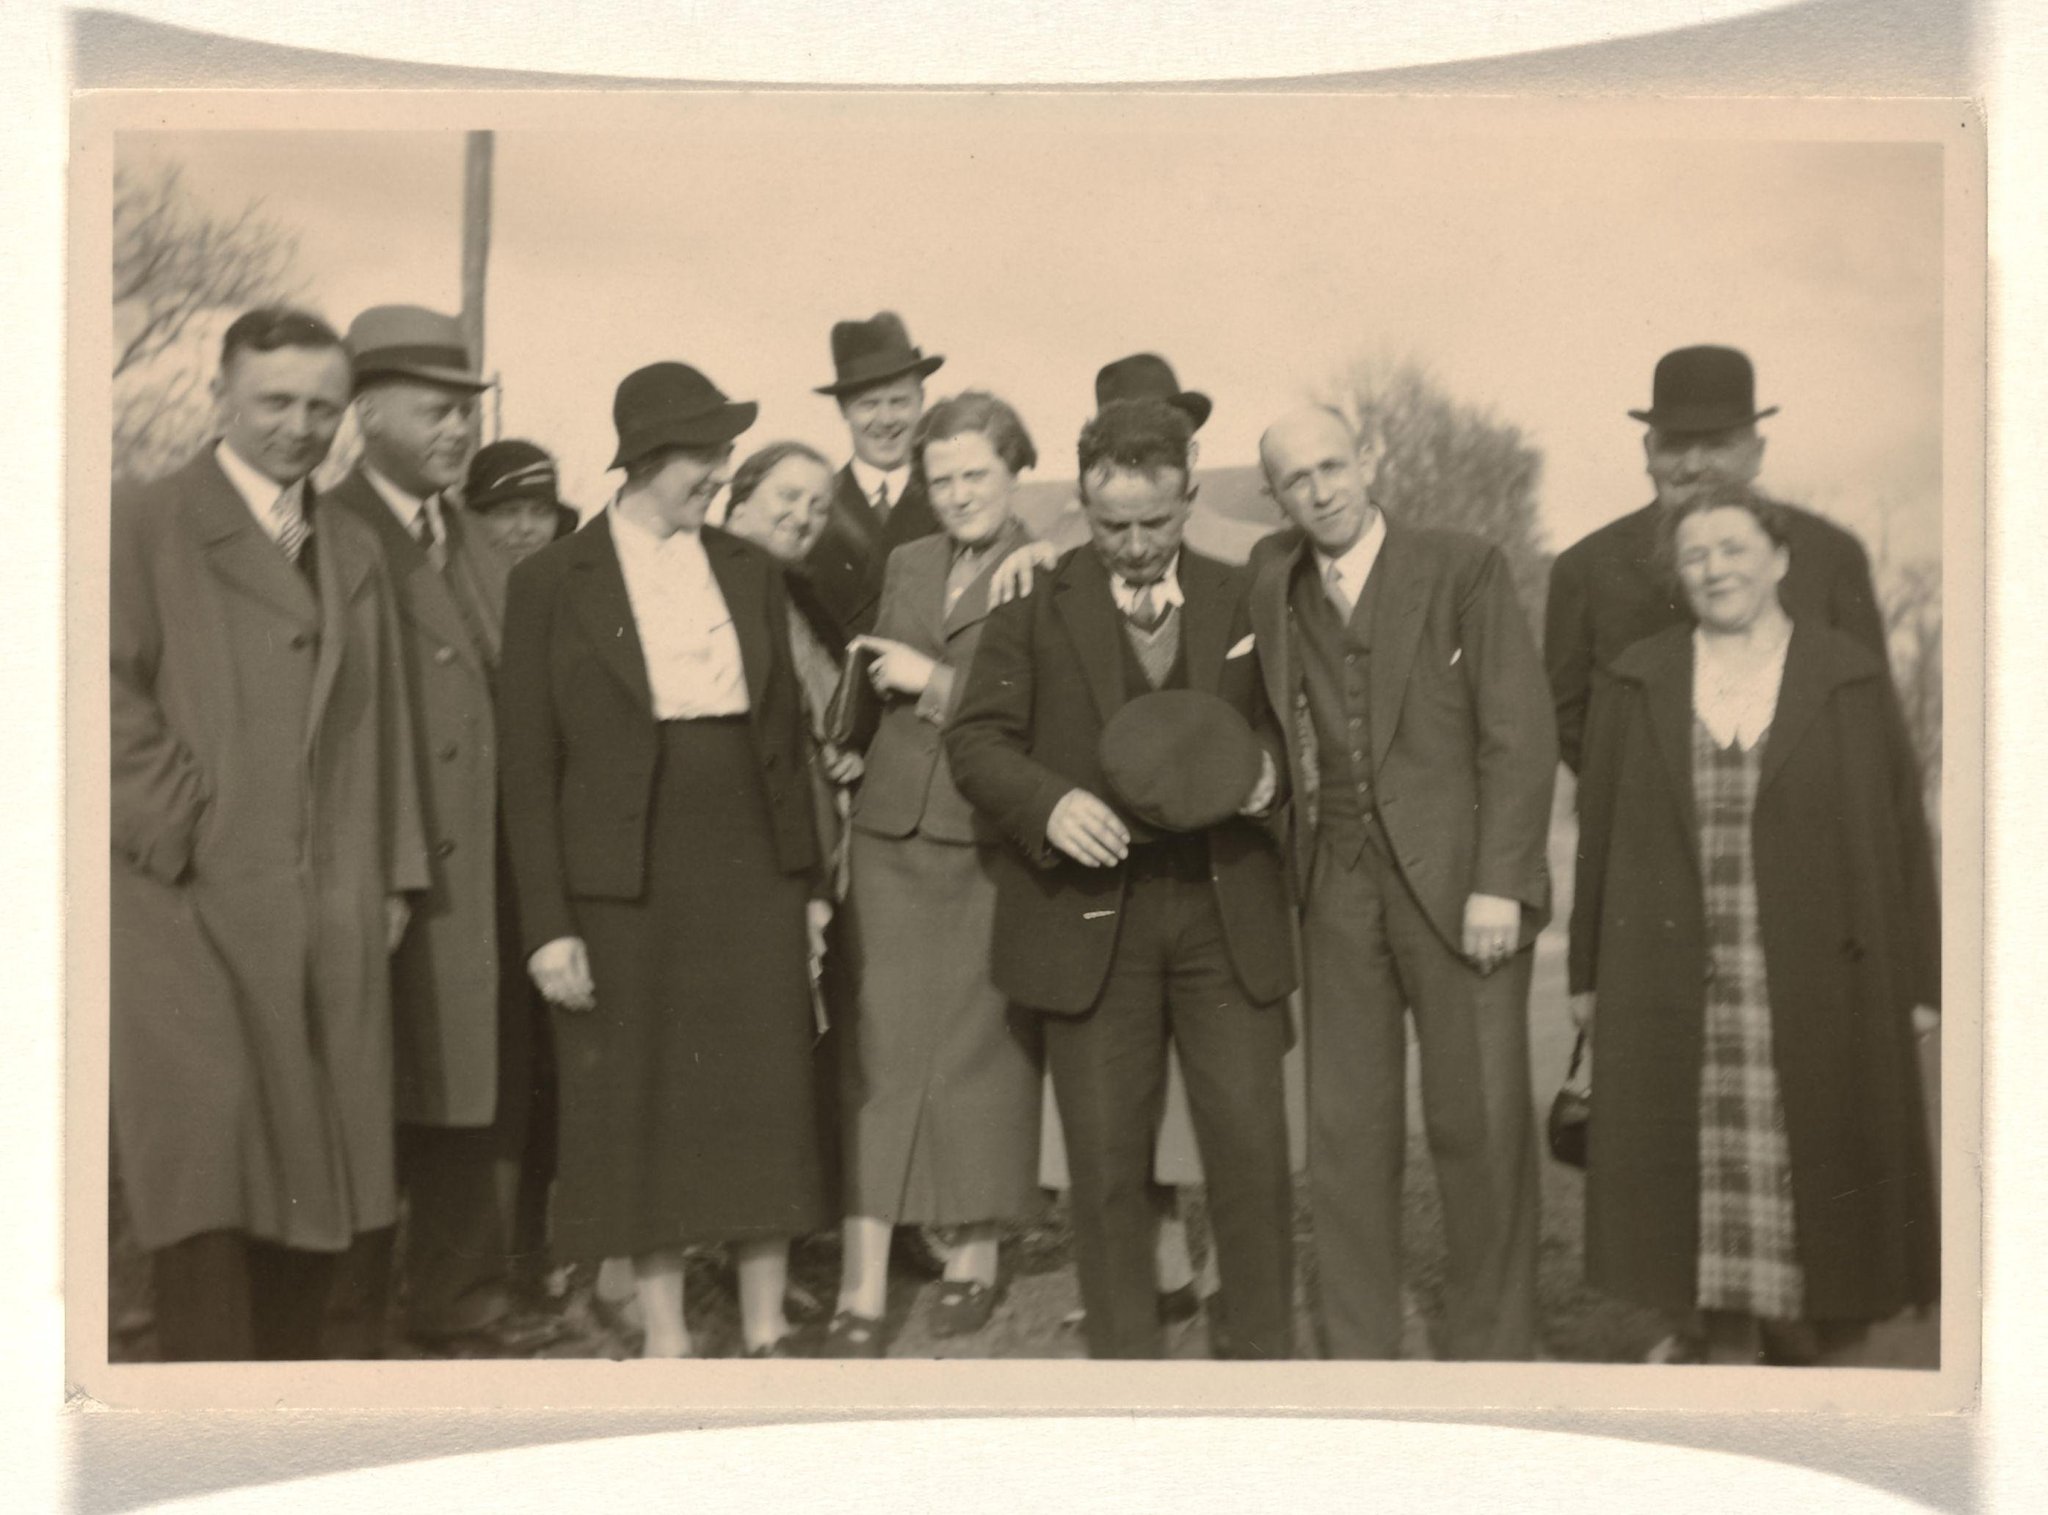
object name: photograph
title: Groep van onbekende mannen en vrouwen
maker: Anonymous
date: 1930-1965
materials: photographic support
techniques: gelatin silver print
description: Groep van onbekende mannen en vrouwen in een rij, waaronder een vrouw met een geblokte jurk, een man met hoed in de hand die naar beneden kijkt, een man met zijn arm om deze man heen geslagen en op de achtergrond een man met gleufhoed.